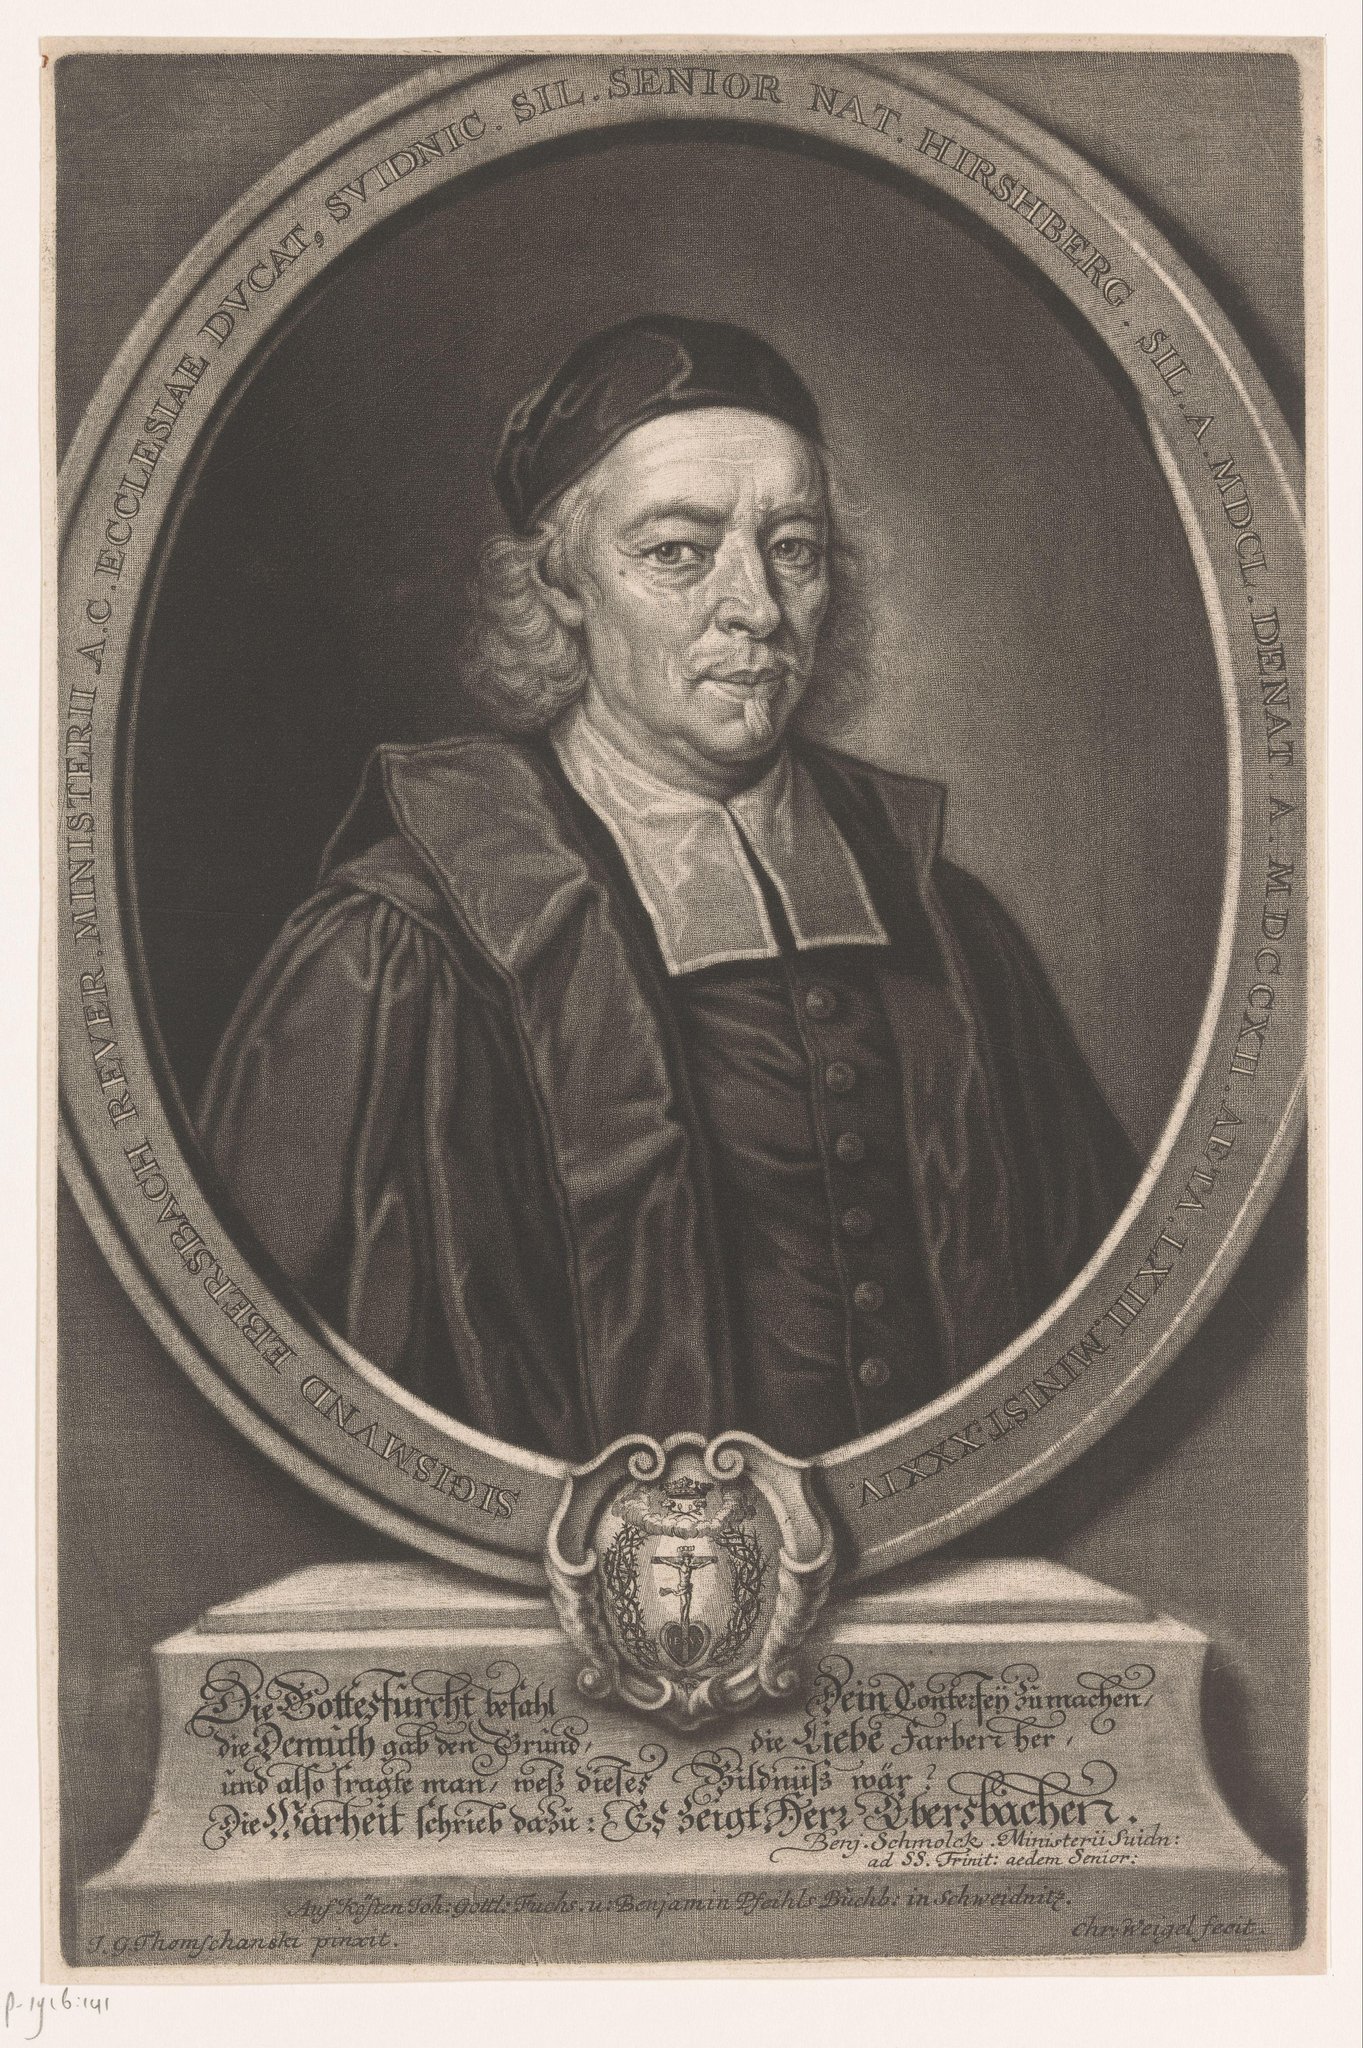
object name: print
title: Portret van Siegmund Ebersbach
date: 1712-1725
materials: paper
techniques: mezzotint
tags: historical persons, armorial bearing, heraldry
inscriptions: collector's mark: Lugt 2228